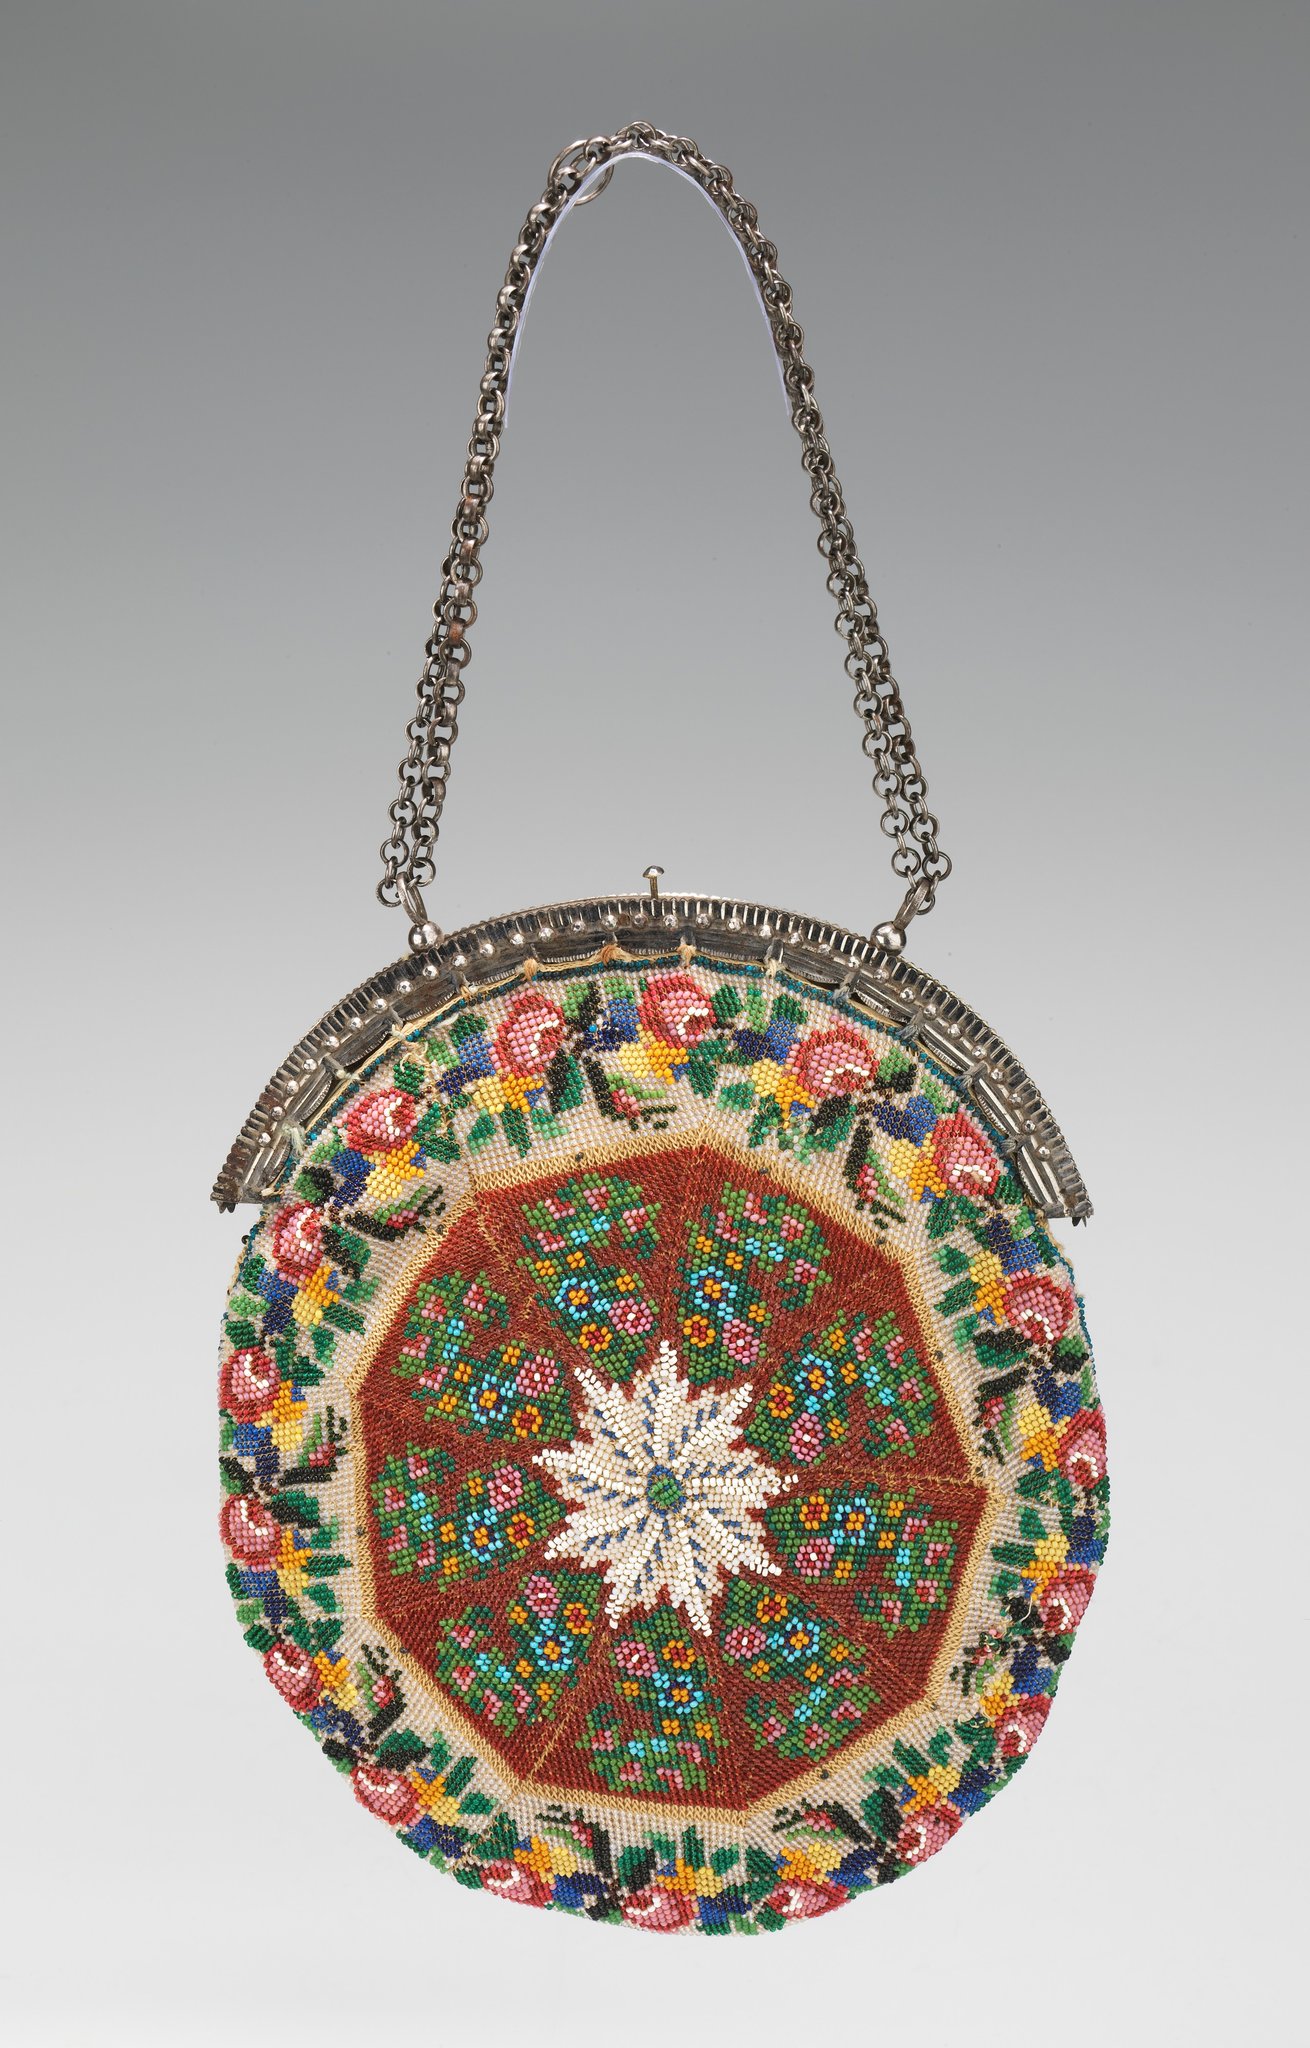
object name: bag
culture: mexican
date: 1876-1900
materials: glass, linen, silk